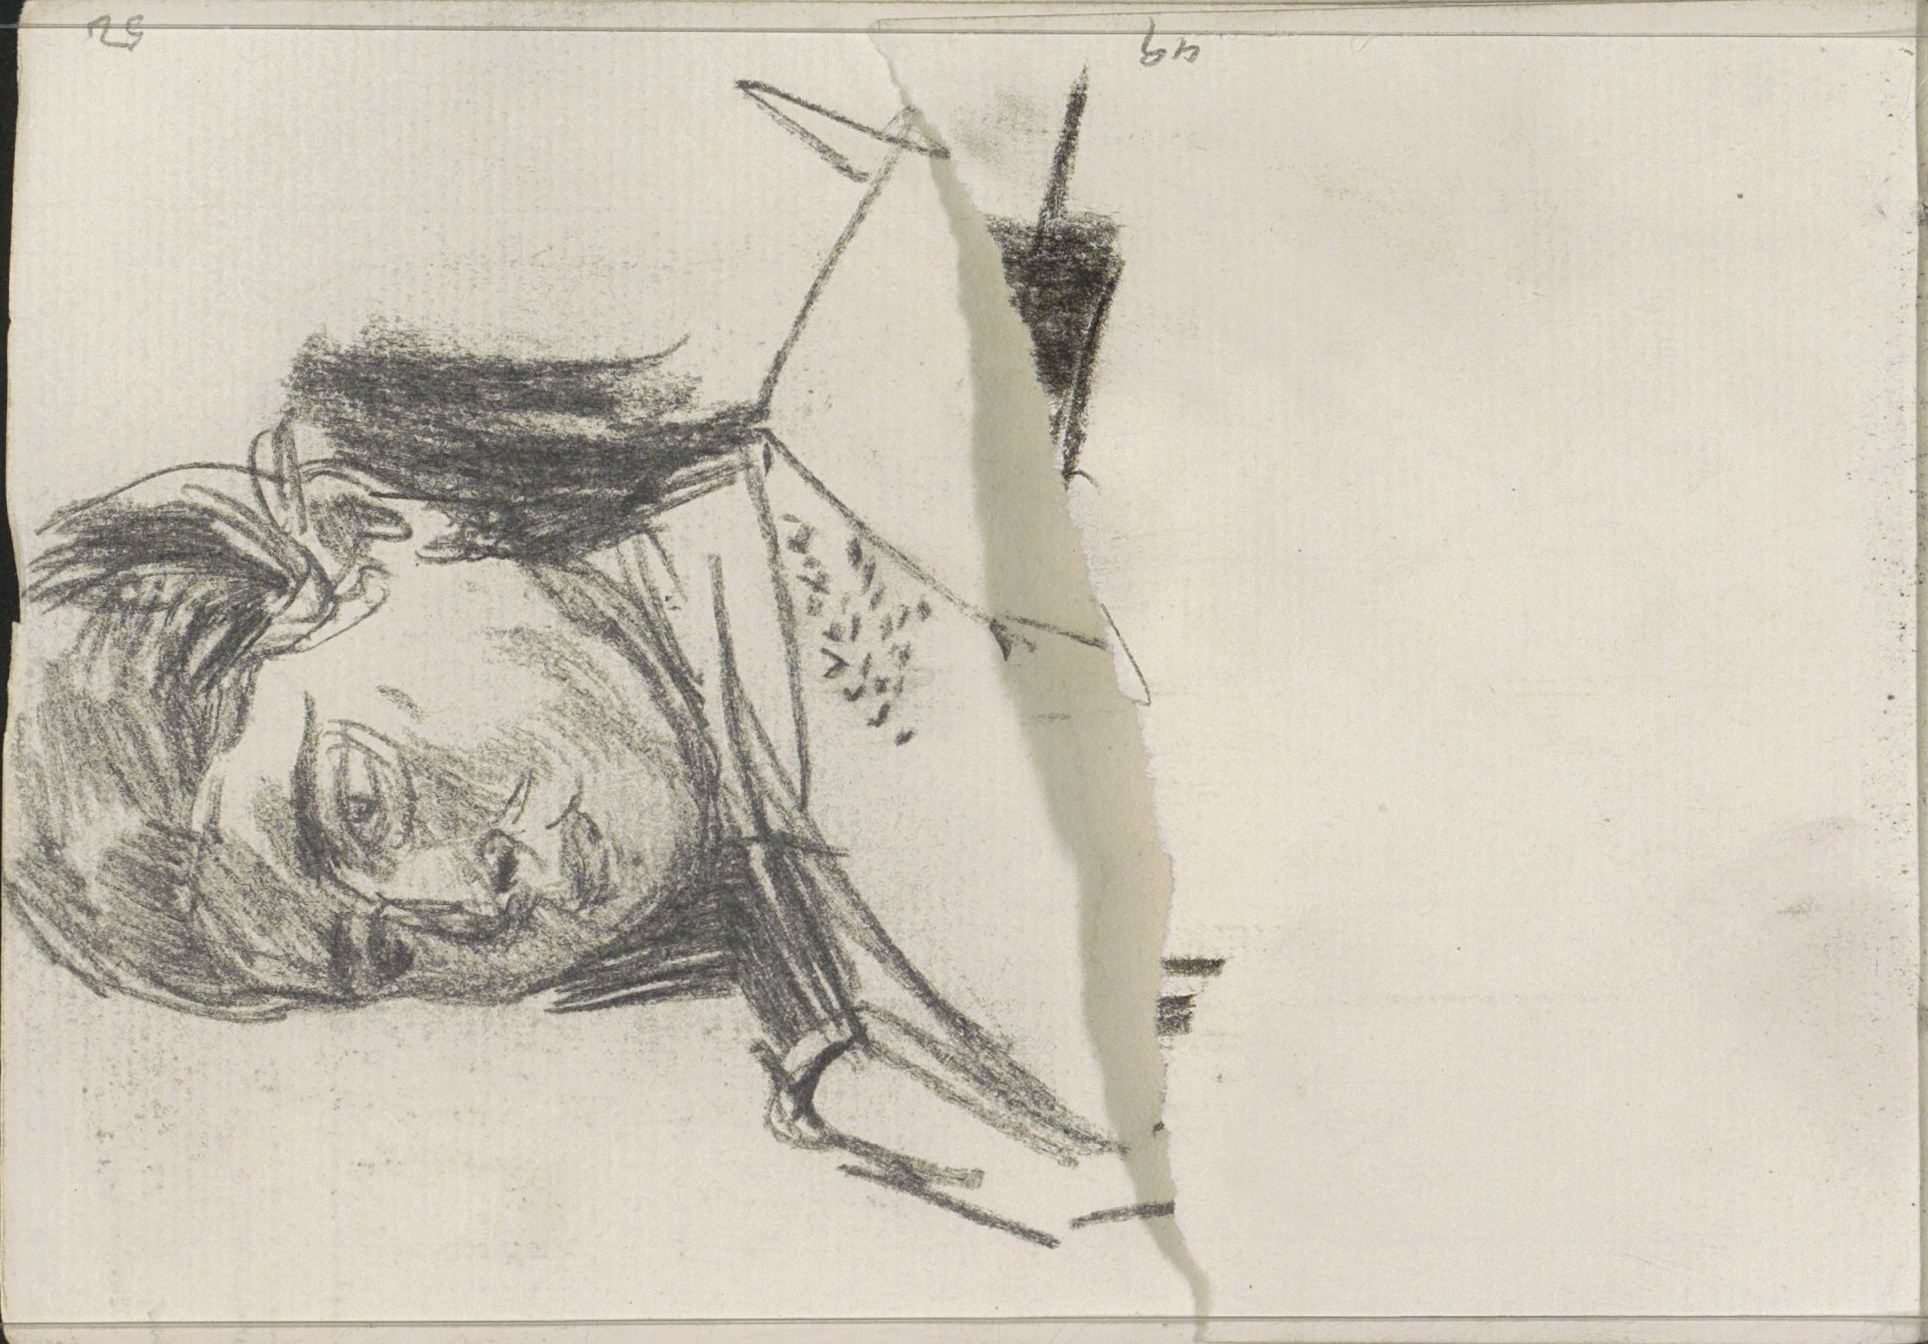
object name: sketchbook leaf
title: Studie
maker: isaac israels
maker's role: draughtsman, painter, print maker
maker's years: 1865-1934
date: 1875-1934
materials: chalk, paper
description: Blad 4 verso uit schetsboek LVI met 26 bladen.